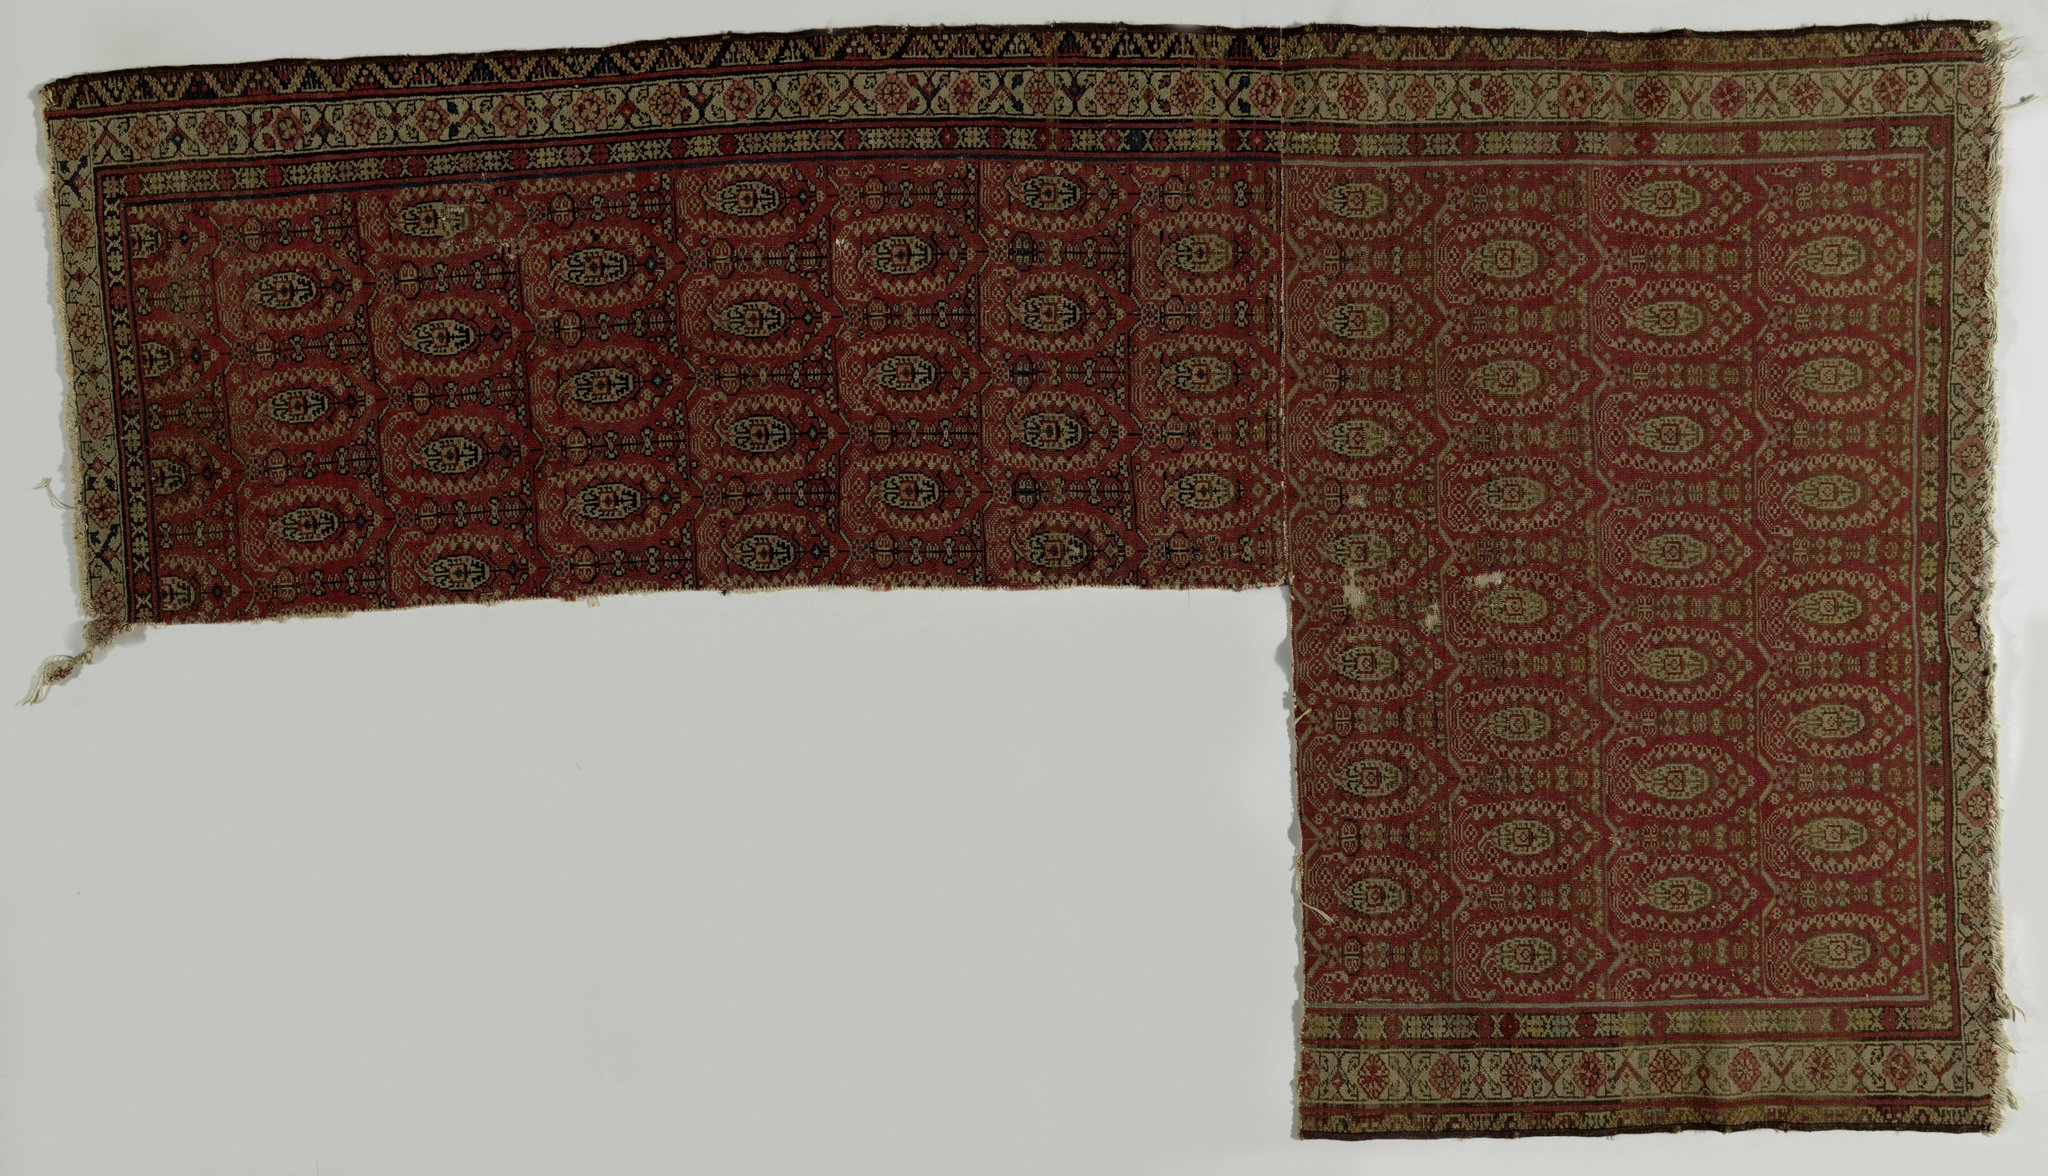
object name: oriental rug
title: Fragment van een oosters tapijt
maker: Anonymous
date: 1850-1900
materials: wool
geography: senneh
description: Fragment van een oosters tapijt met een patroon van samengestelde botehs binnen een raster. Het fletsrode veld wordt omlijst door een drievoudige rand met gestileerde florale en geometrische ornamenten.